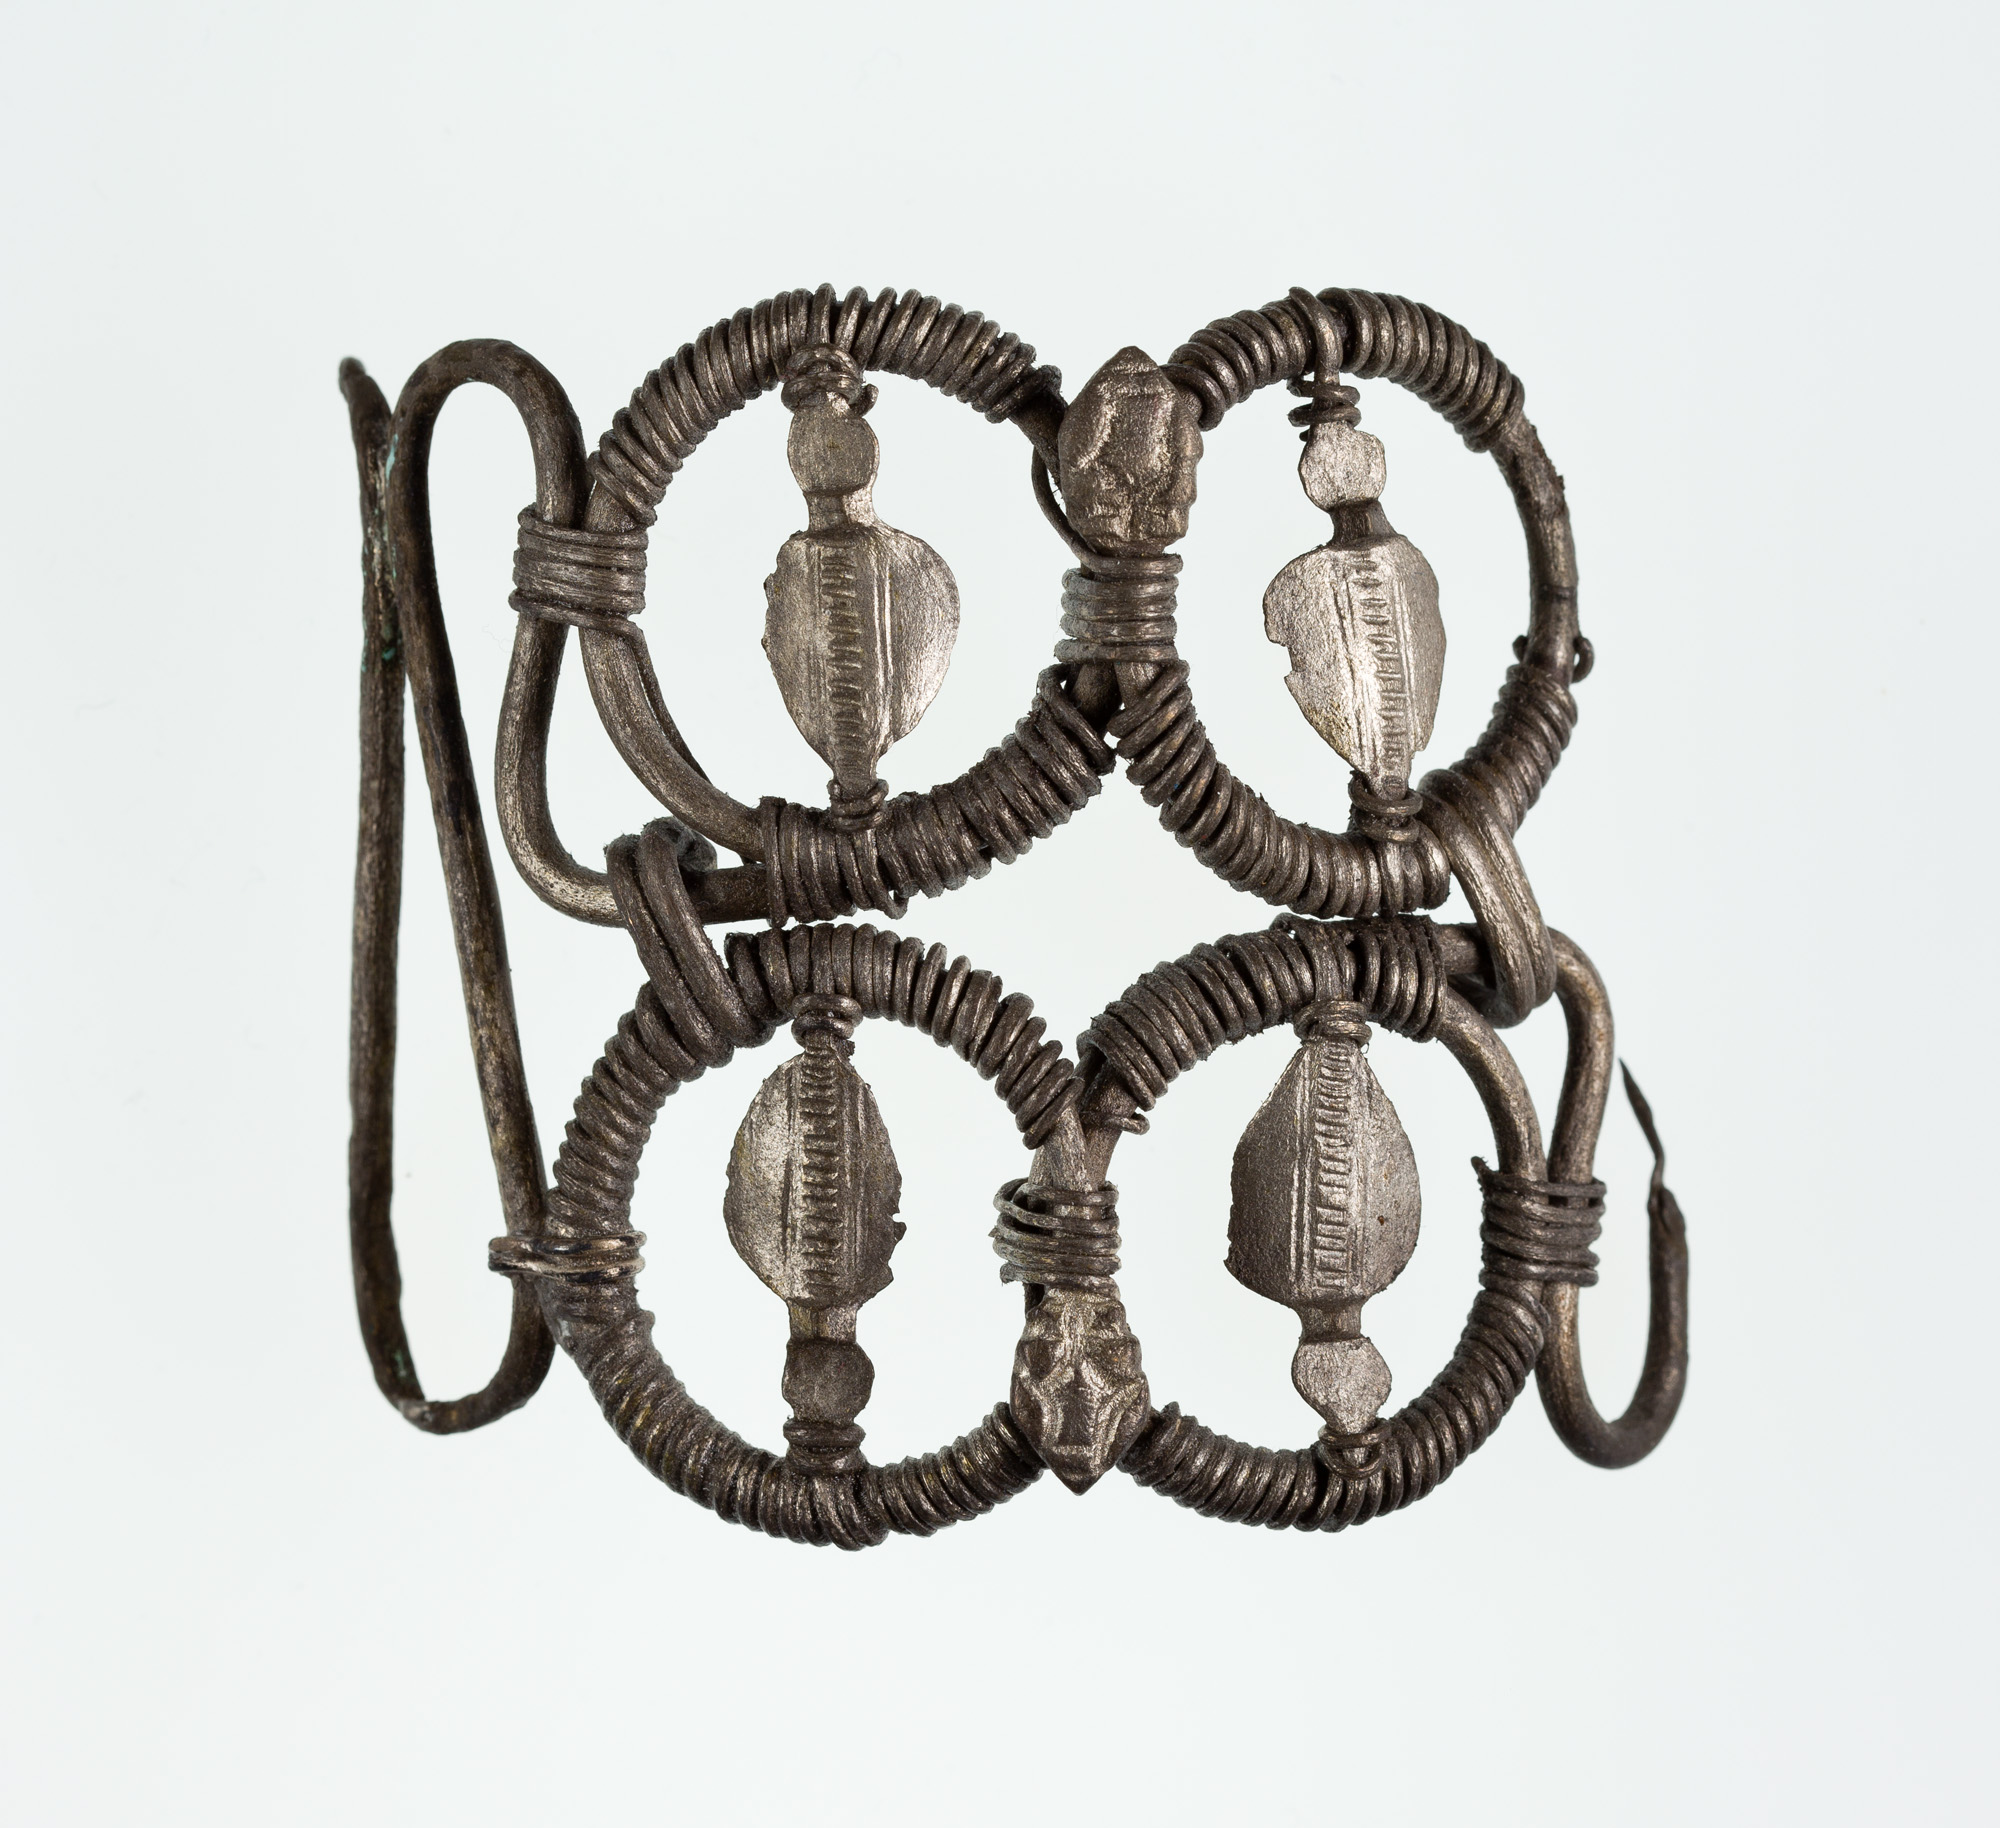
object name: bracelet or armlet, uraei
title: Part (?) of a bracelet or armlet with uraei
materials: silver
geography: egypt